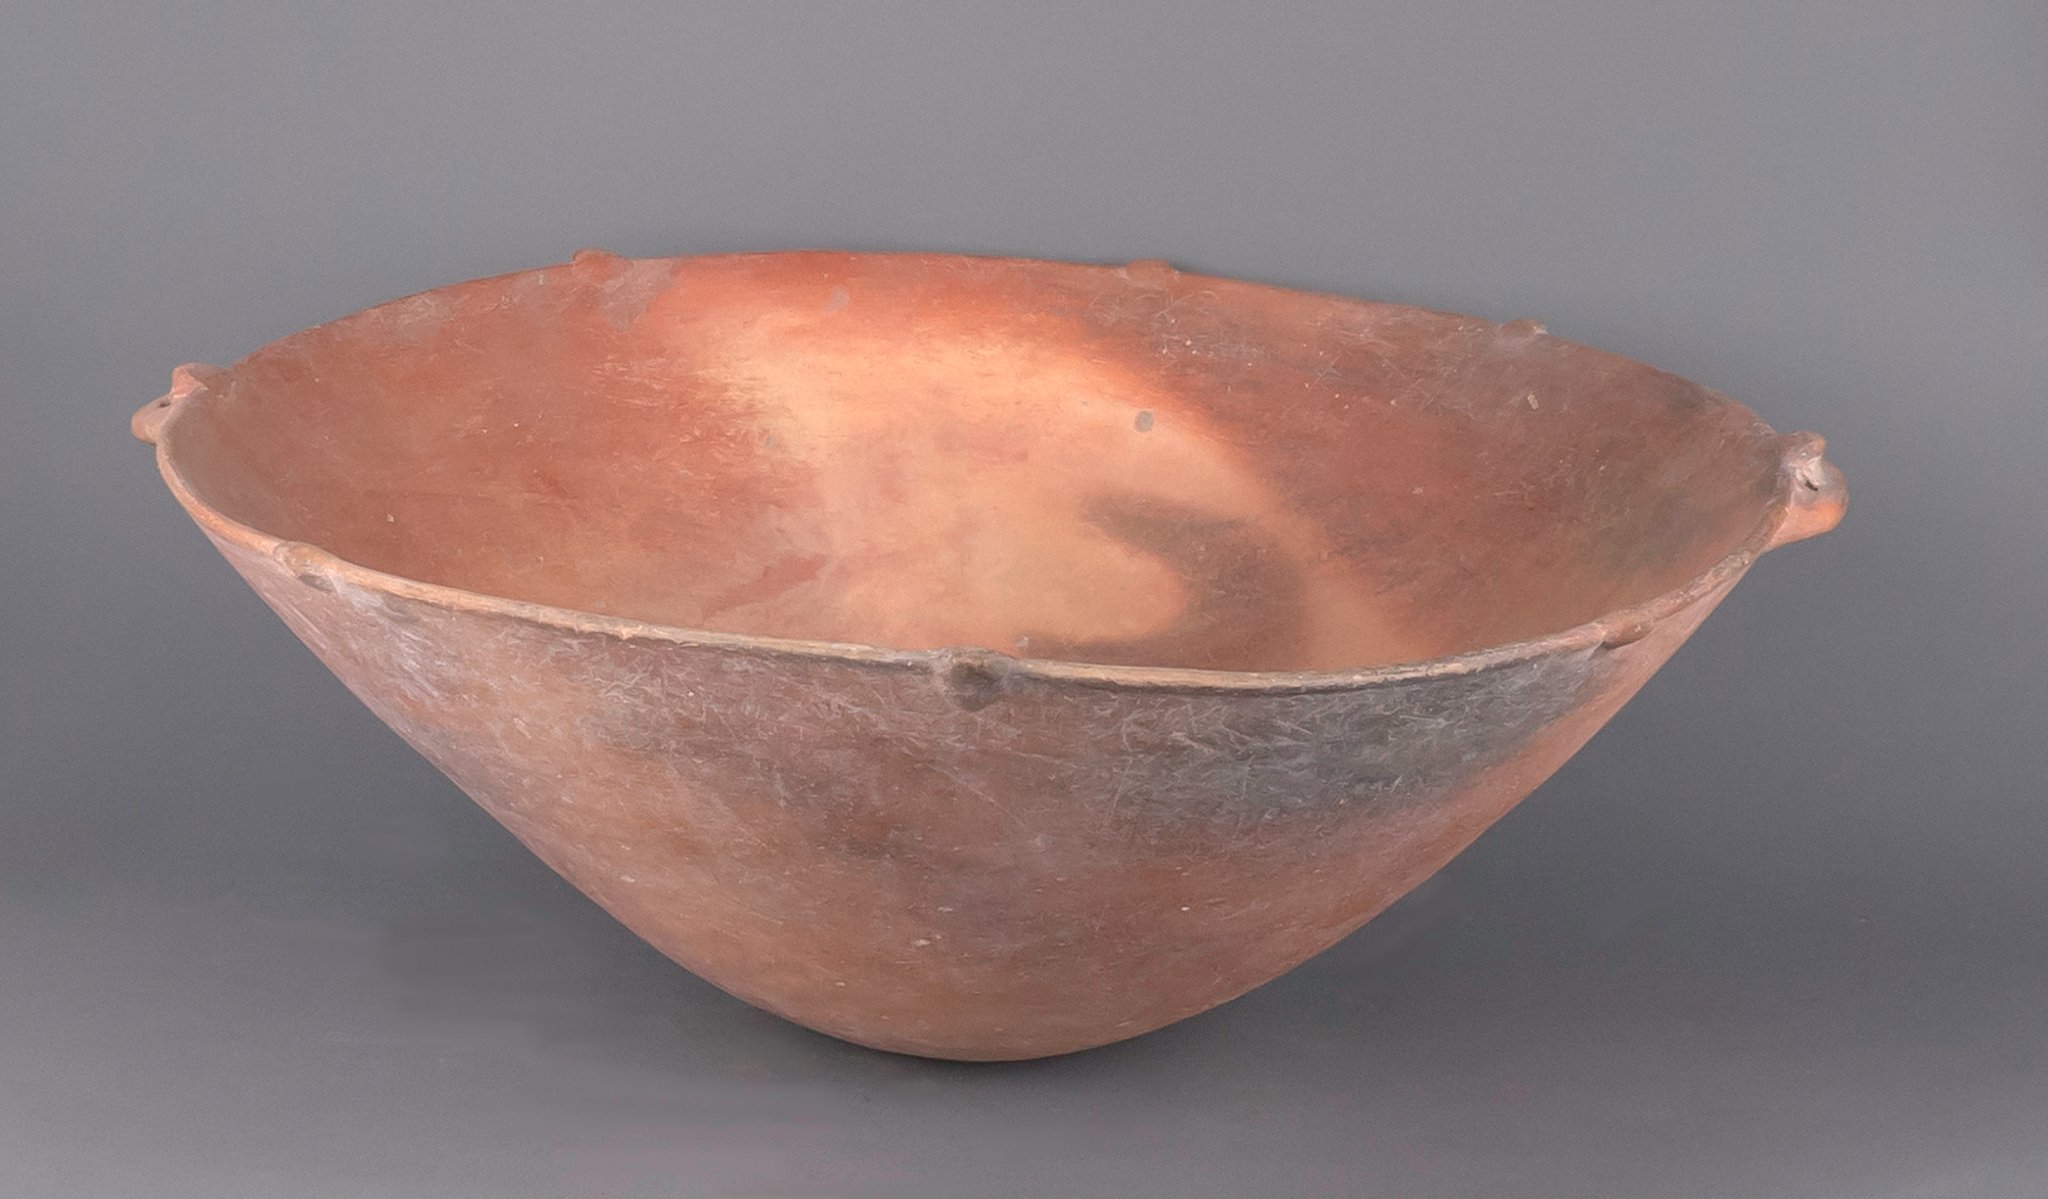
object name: milk bowl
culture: cypriot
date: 3200-1050 BCE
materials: terracotta